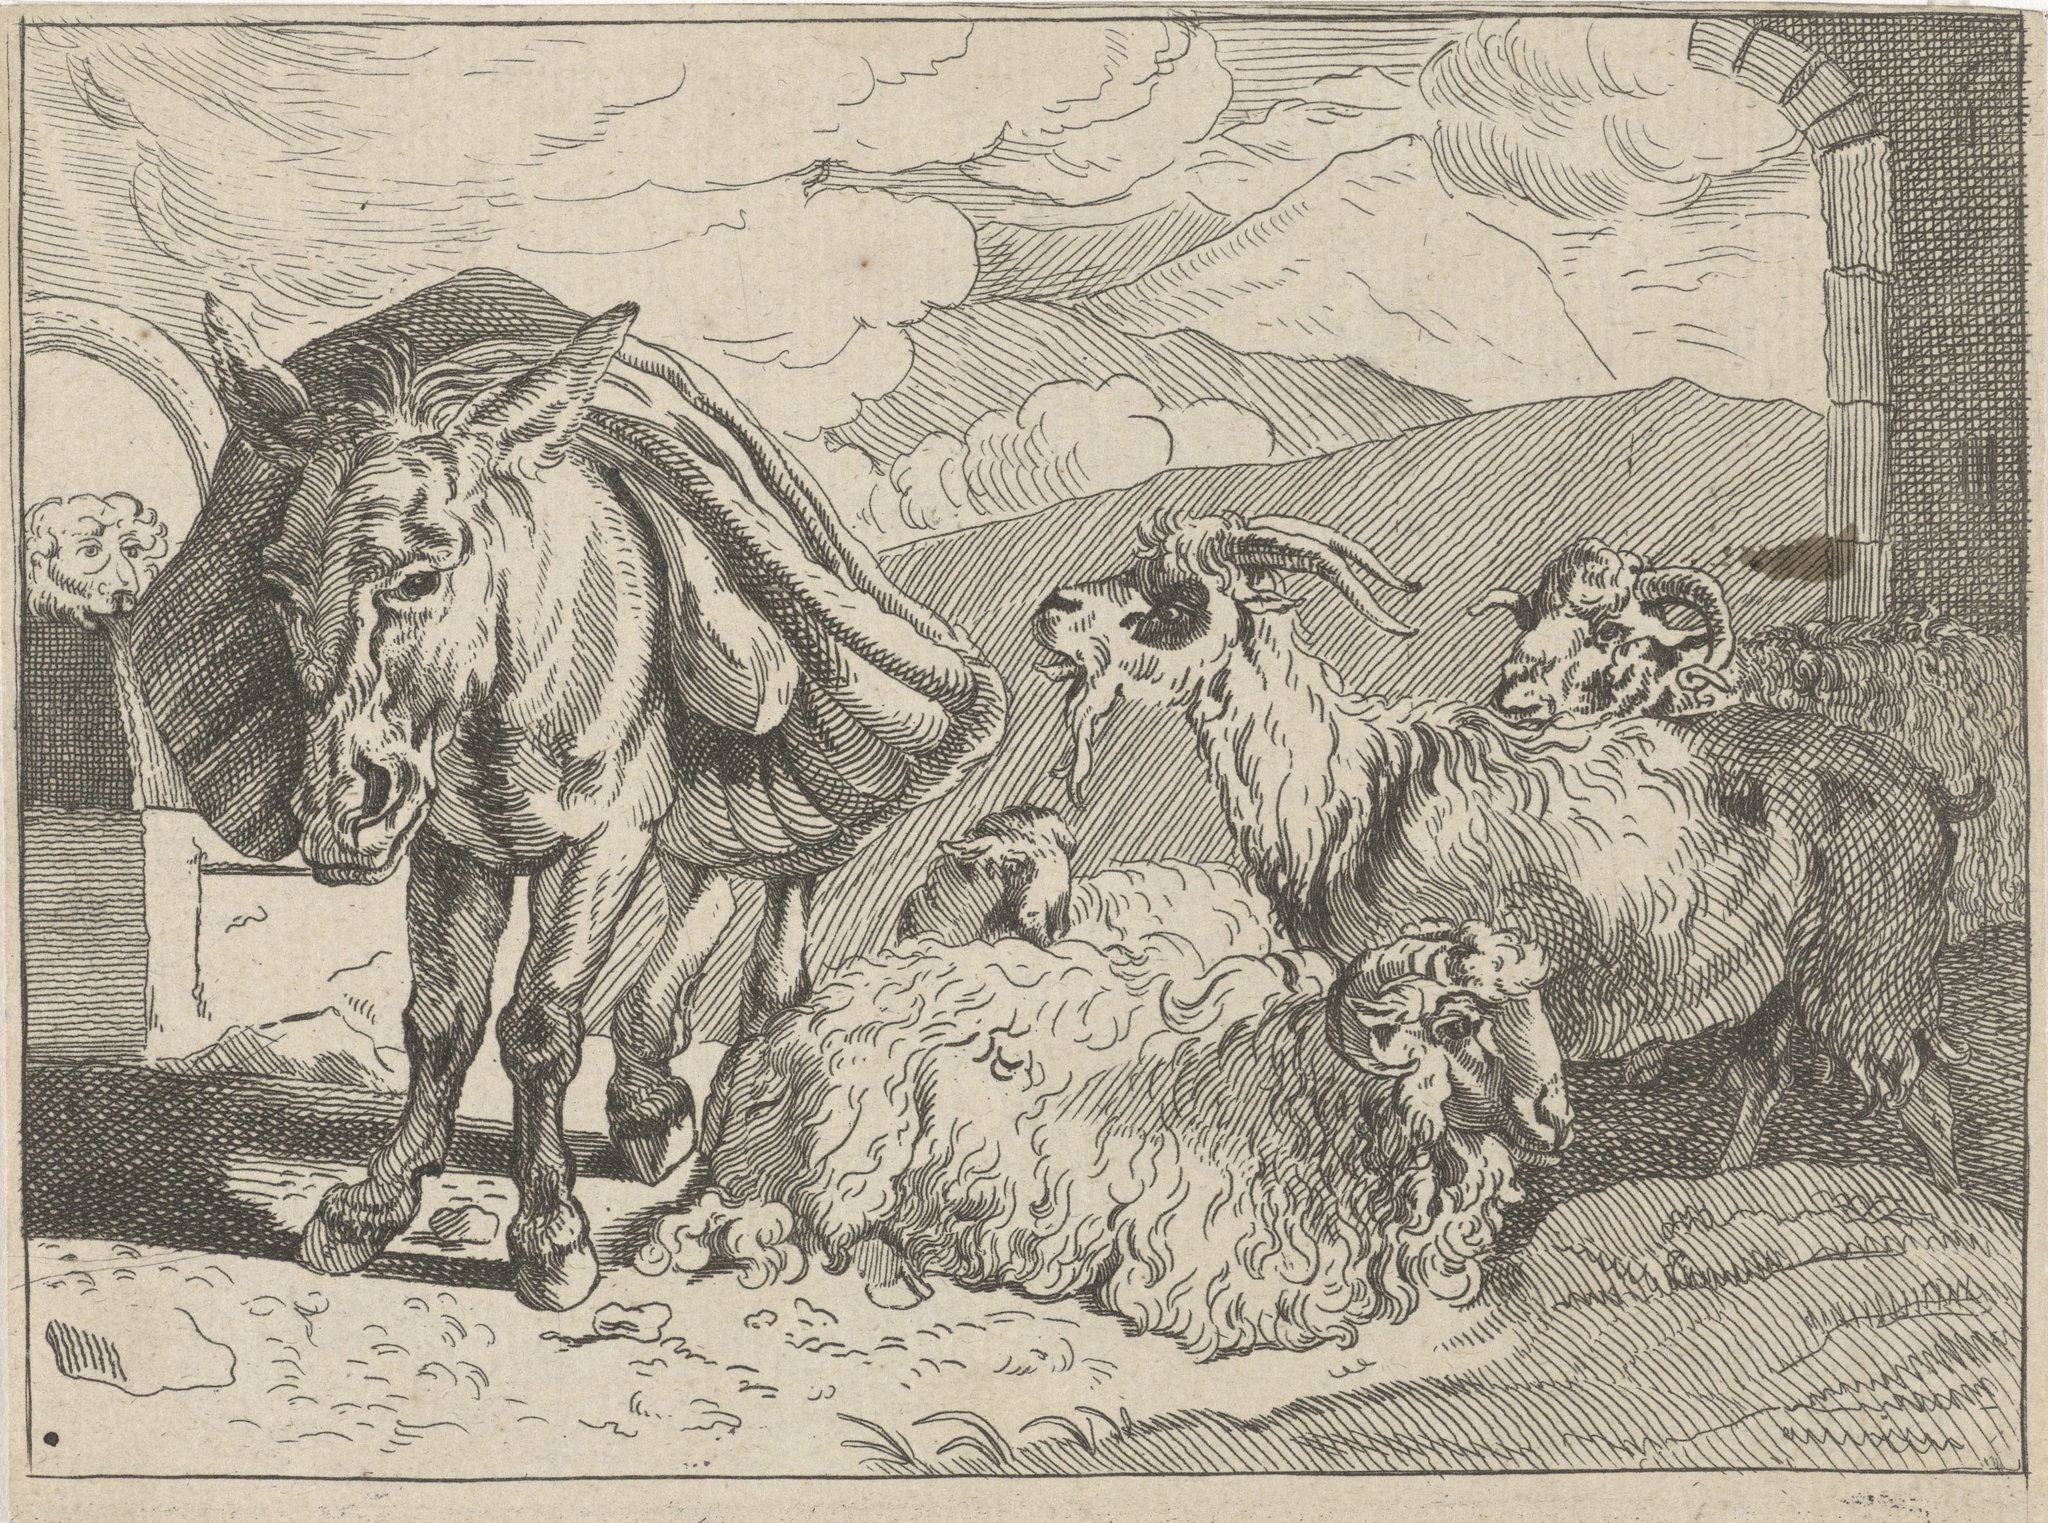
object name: print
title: Ezel, schapen en een geit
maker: Anonymous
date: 1655-1738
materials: paper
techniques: etching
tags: ass, donkey, sheep, goat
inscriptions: collector's mark: Lugt 2165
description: Kopie naar gelijknamige prent uit een negendelige serie prenten met voorstellingen van diverse dieren door Govert van der Leeuw.